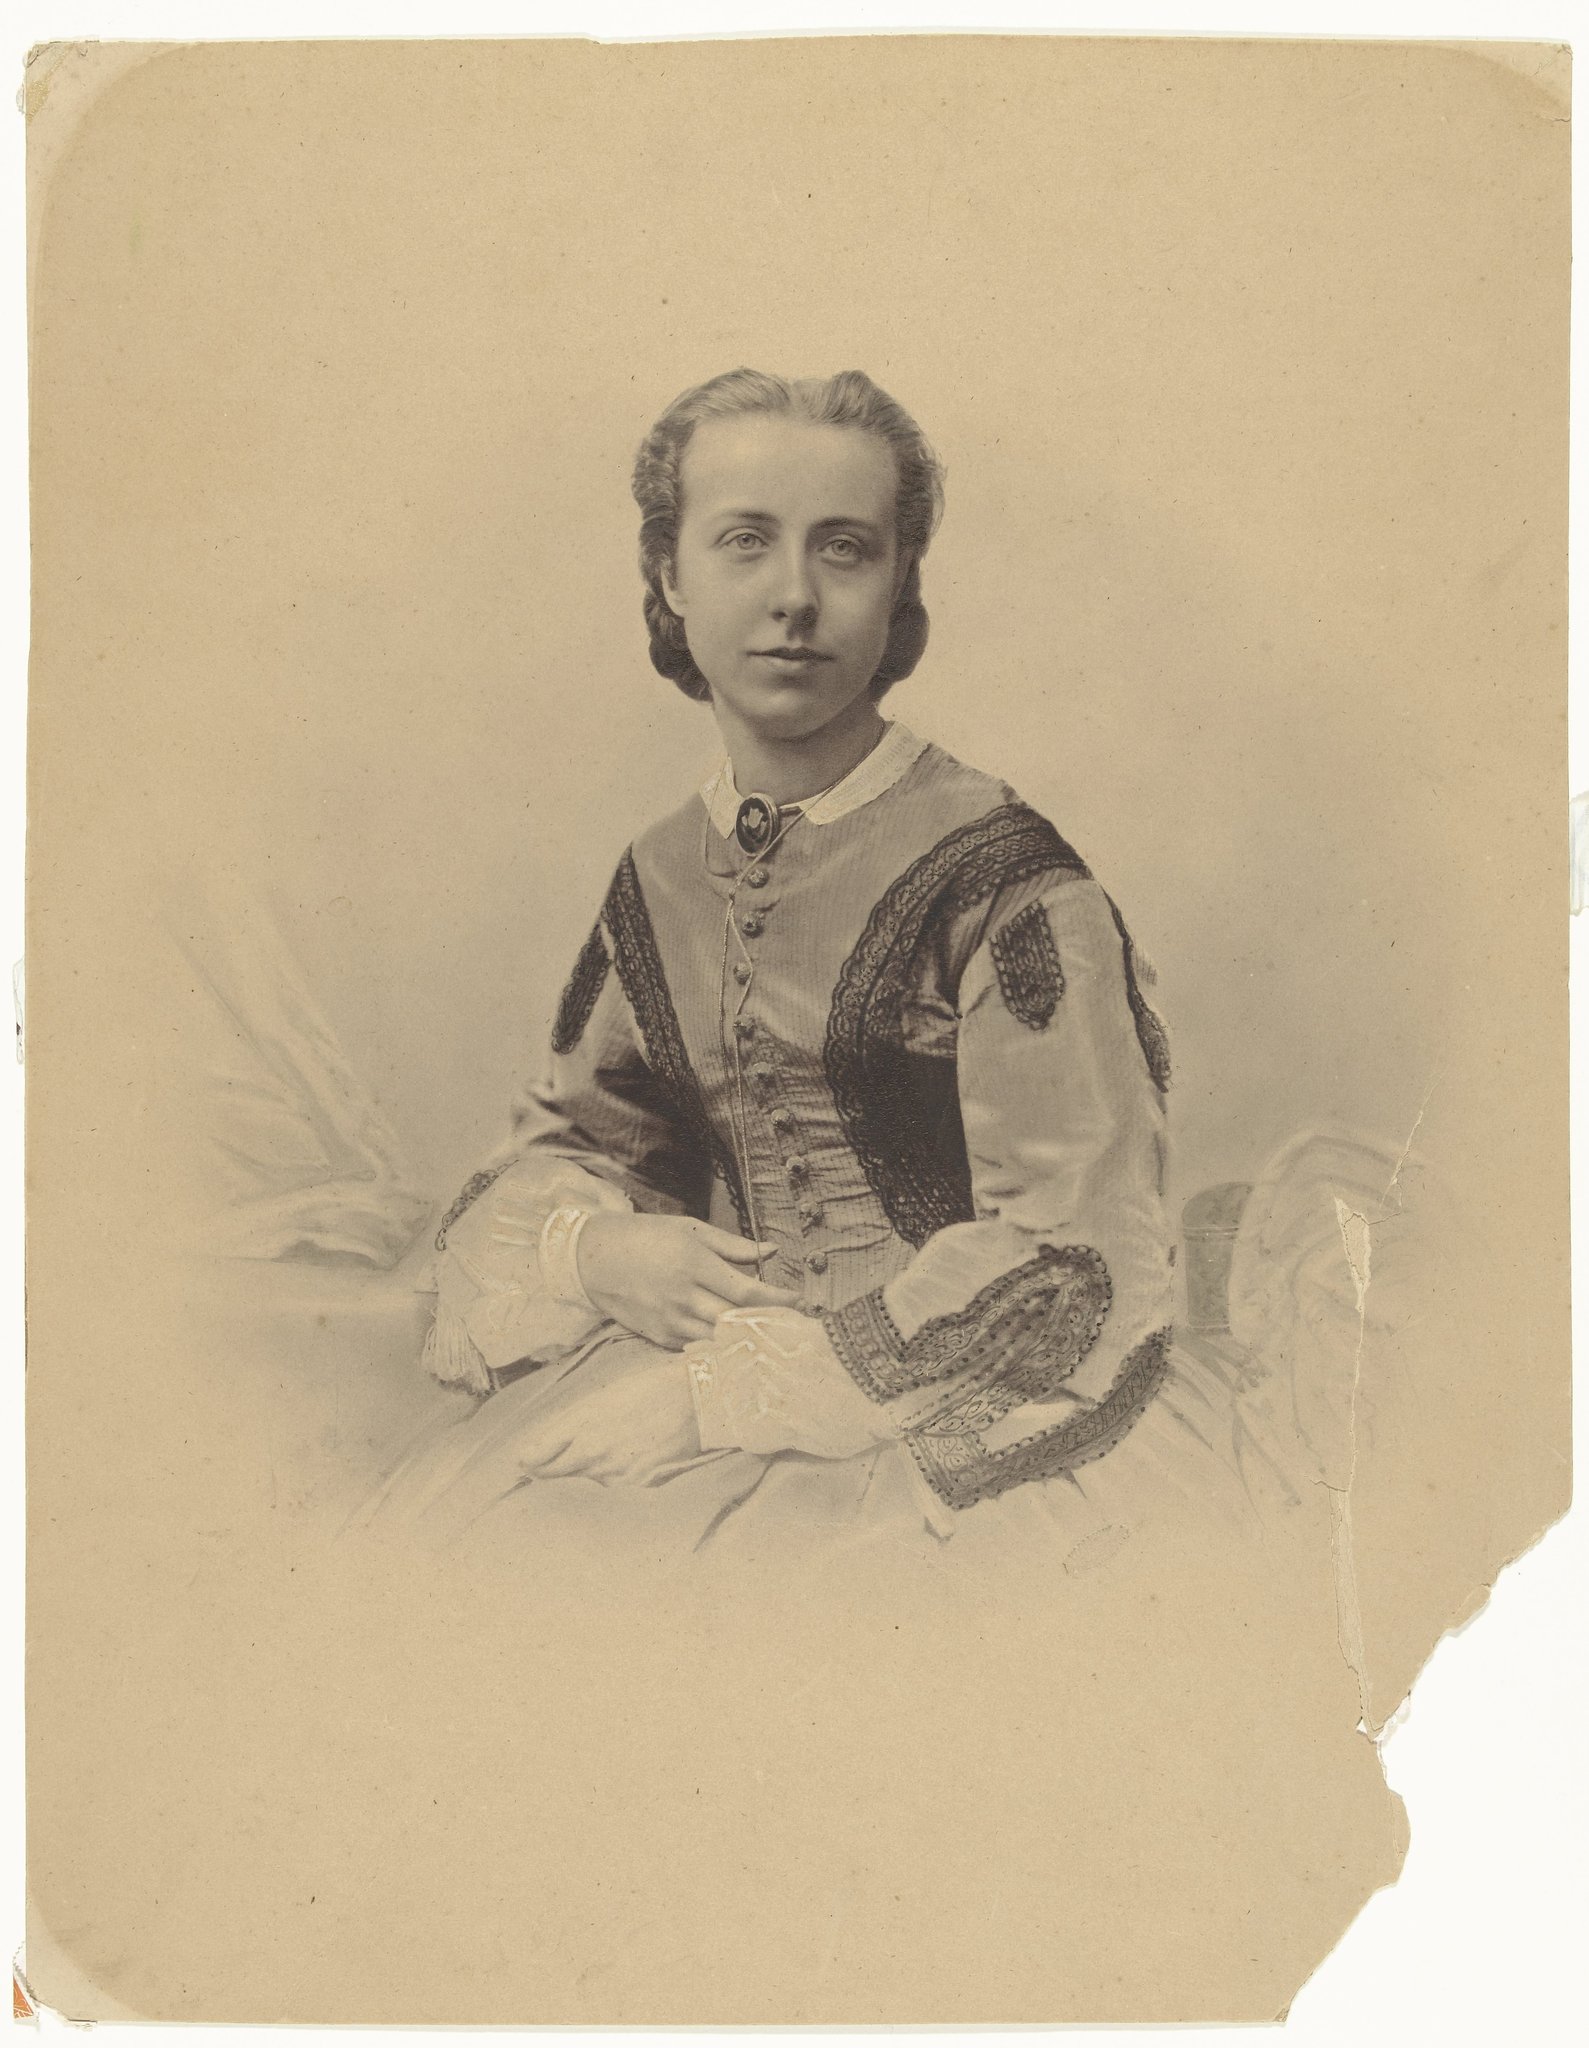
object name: photograph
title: Portret van een jonge vrouw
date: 1870-1900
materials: cardboard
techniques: carbon print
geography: amsterdam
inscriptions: check stamp: ‘KOOLDRUK//WEGNER & MOTTU’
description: Portret van een jonge vrouw, met een jurk met kant bestikte jurk, zilveren dunne ketting.